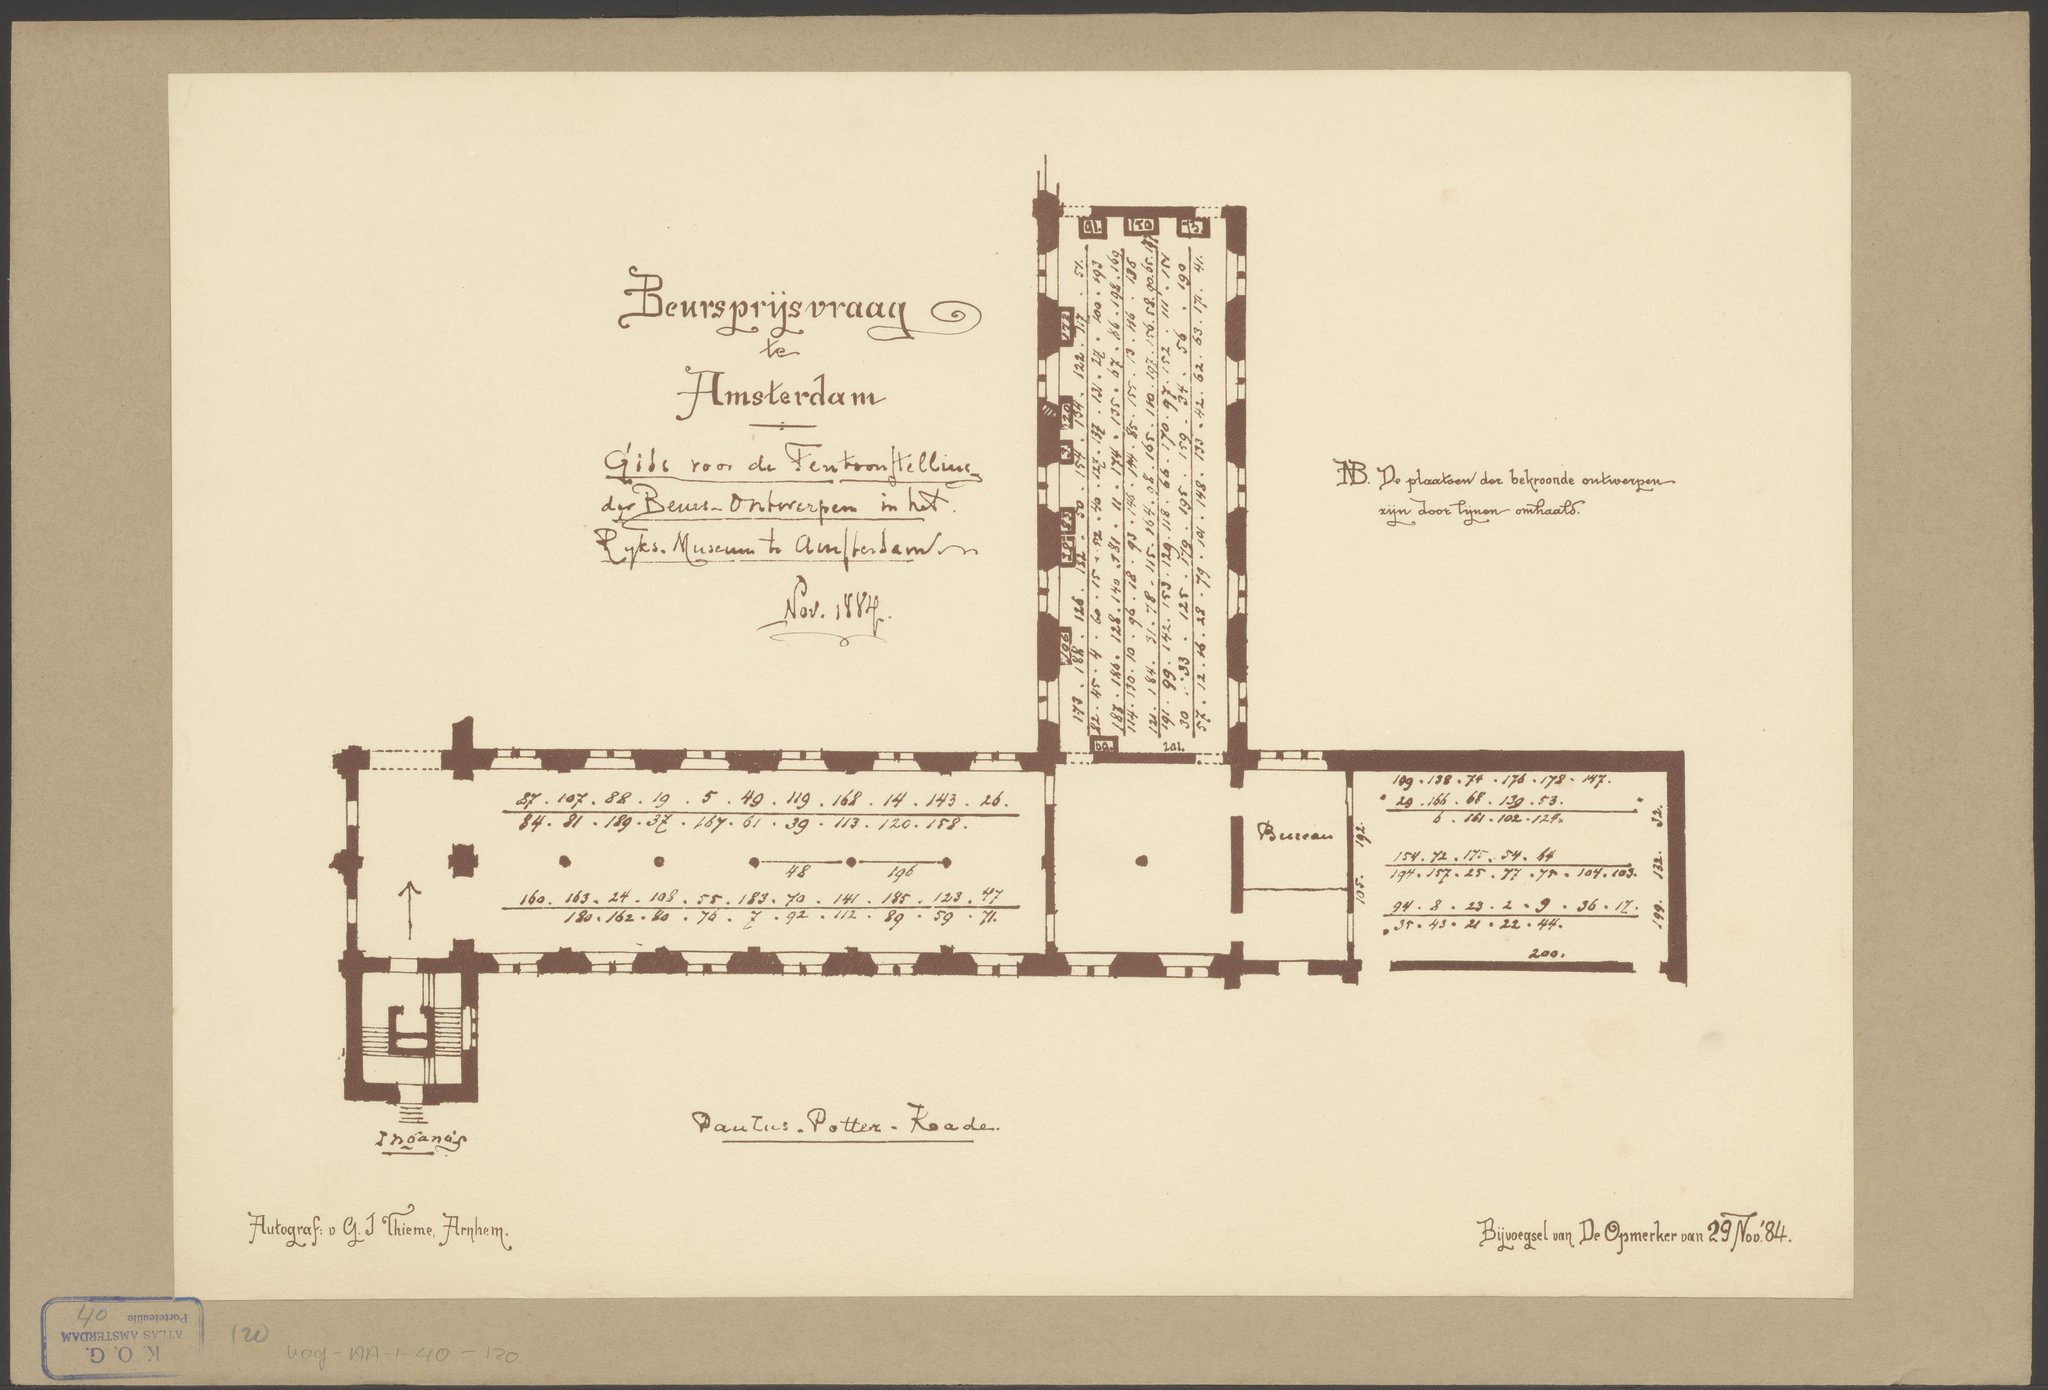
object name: photomechanical print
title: Beursprijsvraag te Amsterdam / Gids voor de Tentoonstelling der Beurs-Ontwerpen in het Rijks-Museum te Amsterdam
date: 1884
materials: paper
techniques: photolithography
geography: arnhem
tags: stock exchange, stock-market, exhibition ~ art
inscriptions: collector's mark: Lugt 1641b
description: Onderwerpsrubriek binnen de Atlas Amsterdam: Handel en Zeevaart, D. Beurs-Ontwerpen.